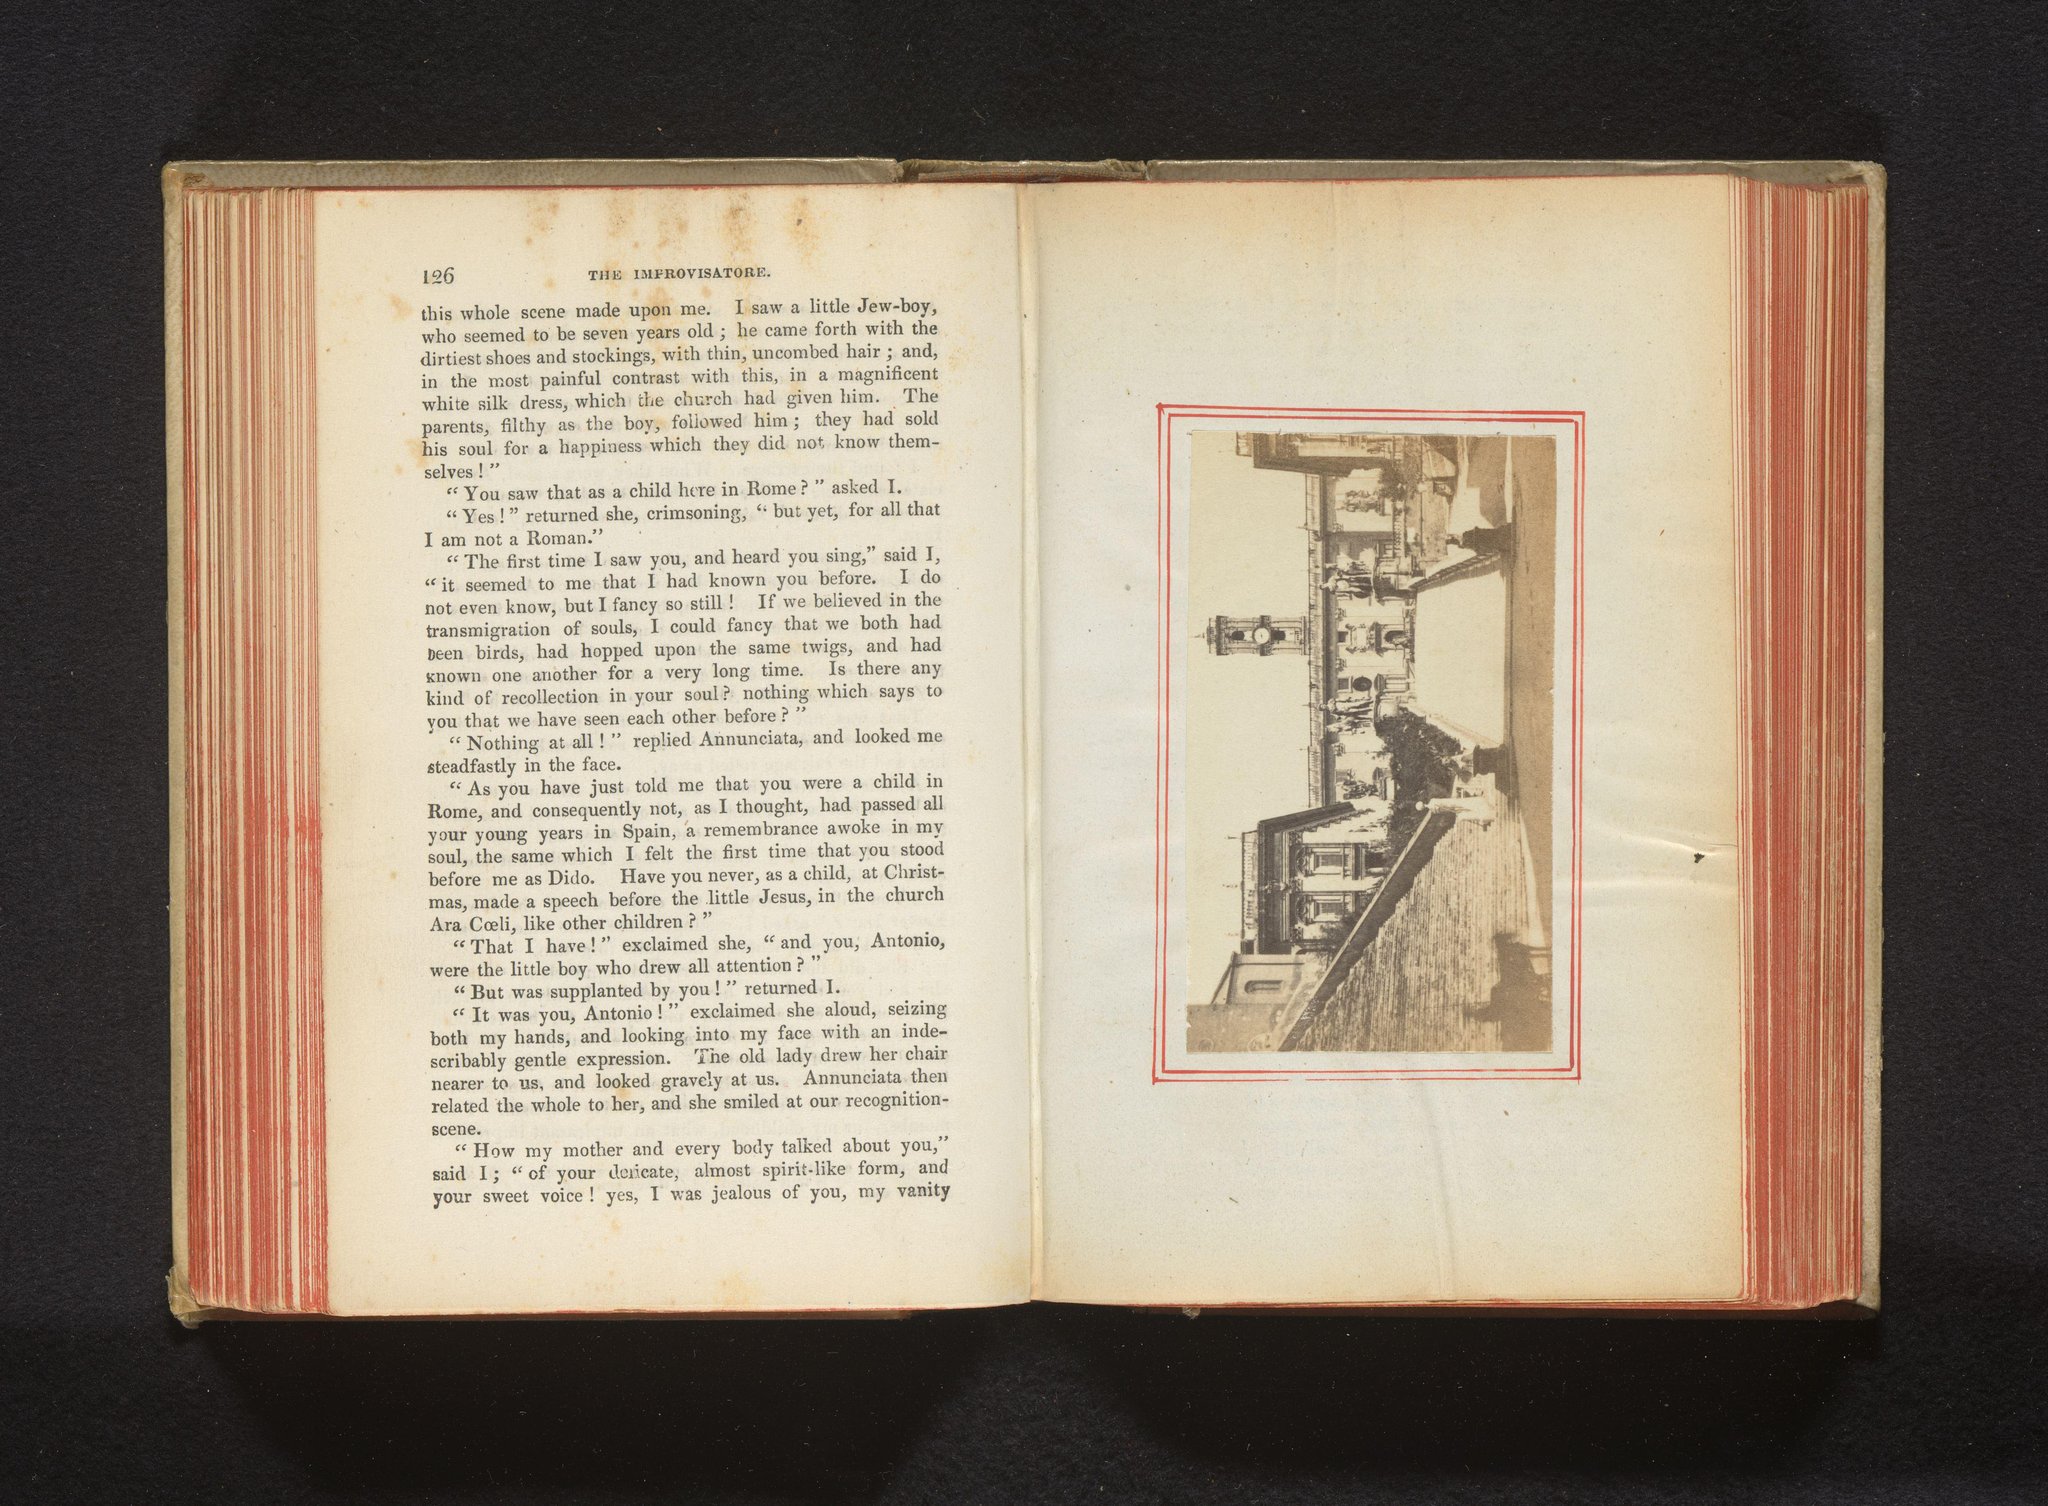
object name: photograph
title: Gezicht op het Piazza del Campidoglio te Rome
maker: Anonymous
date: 1863-1873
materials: photographic support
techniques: albumen print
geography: rome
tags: square, place, circus, etc., façade (of house or building)